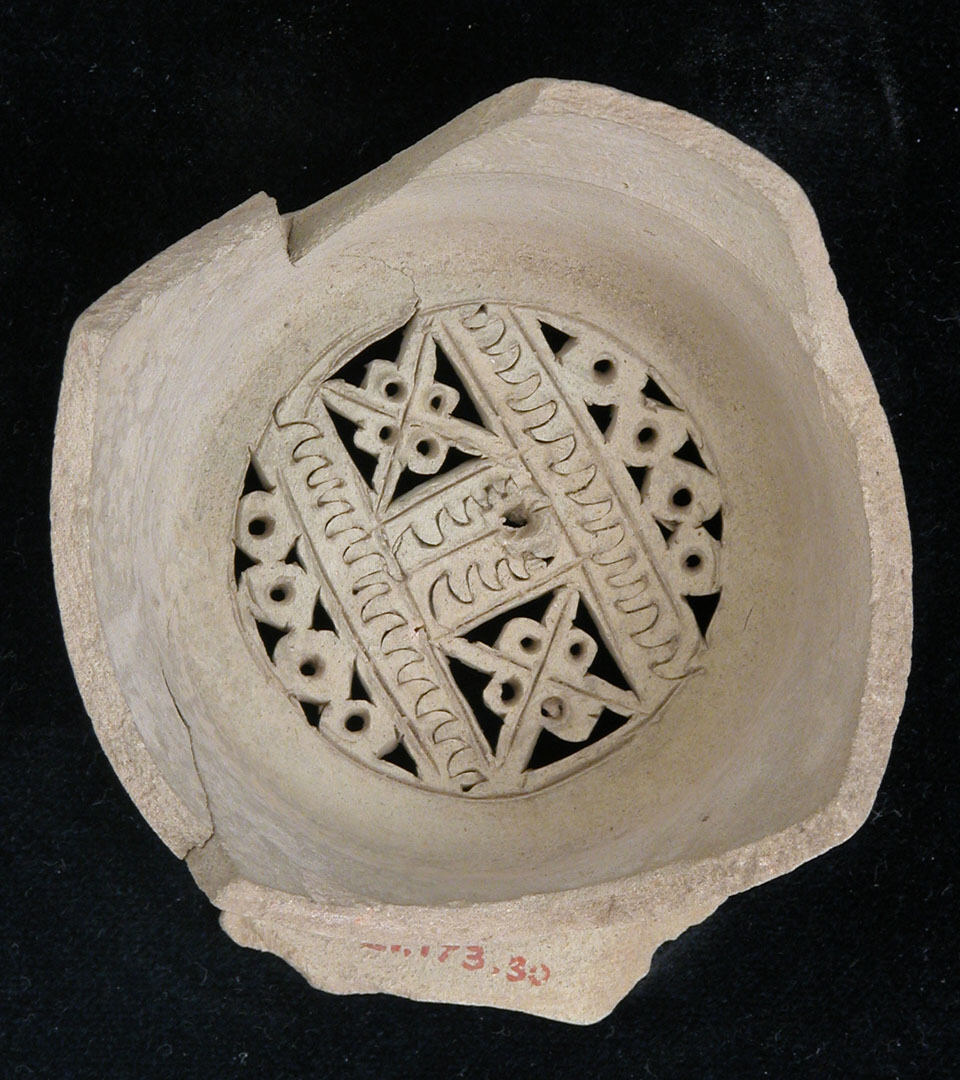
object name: water filter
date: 901-1200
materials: earthenware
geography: egypt